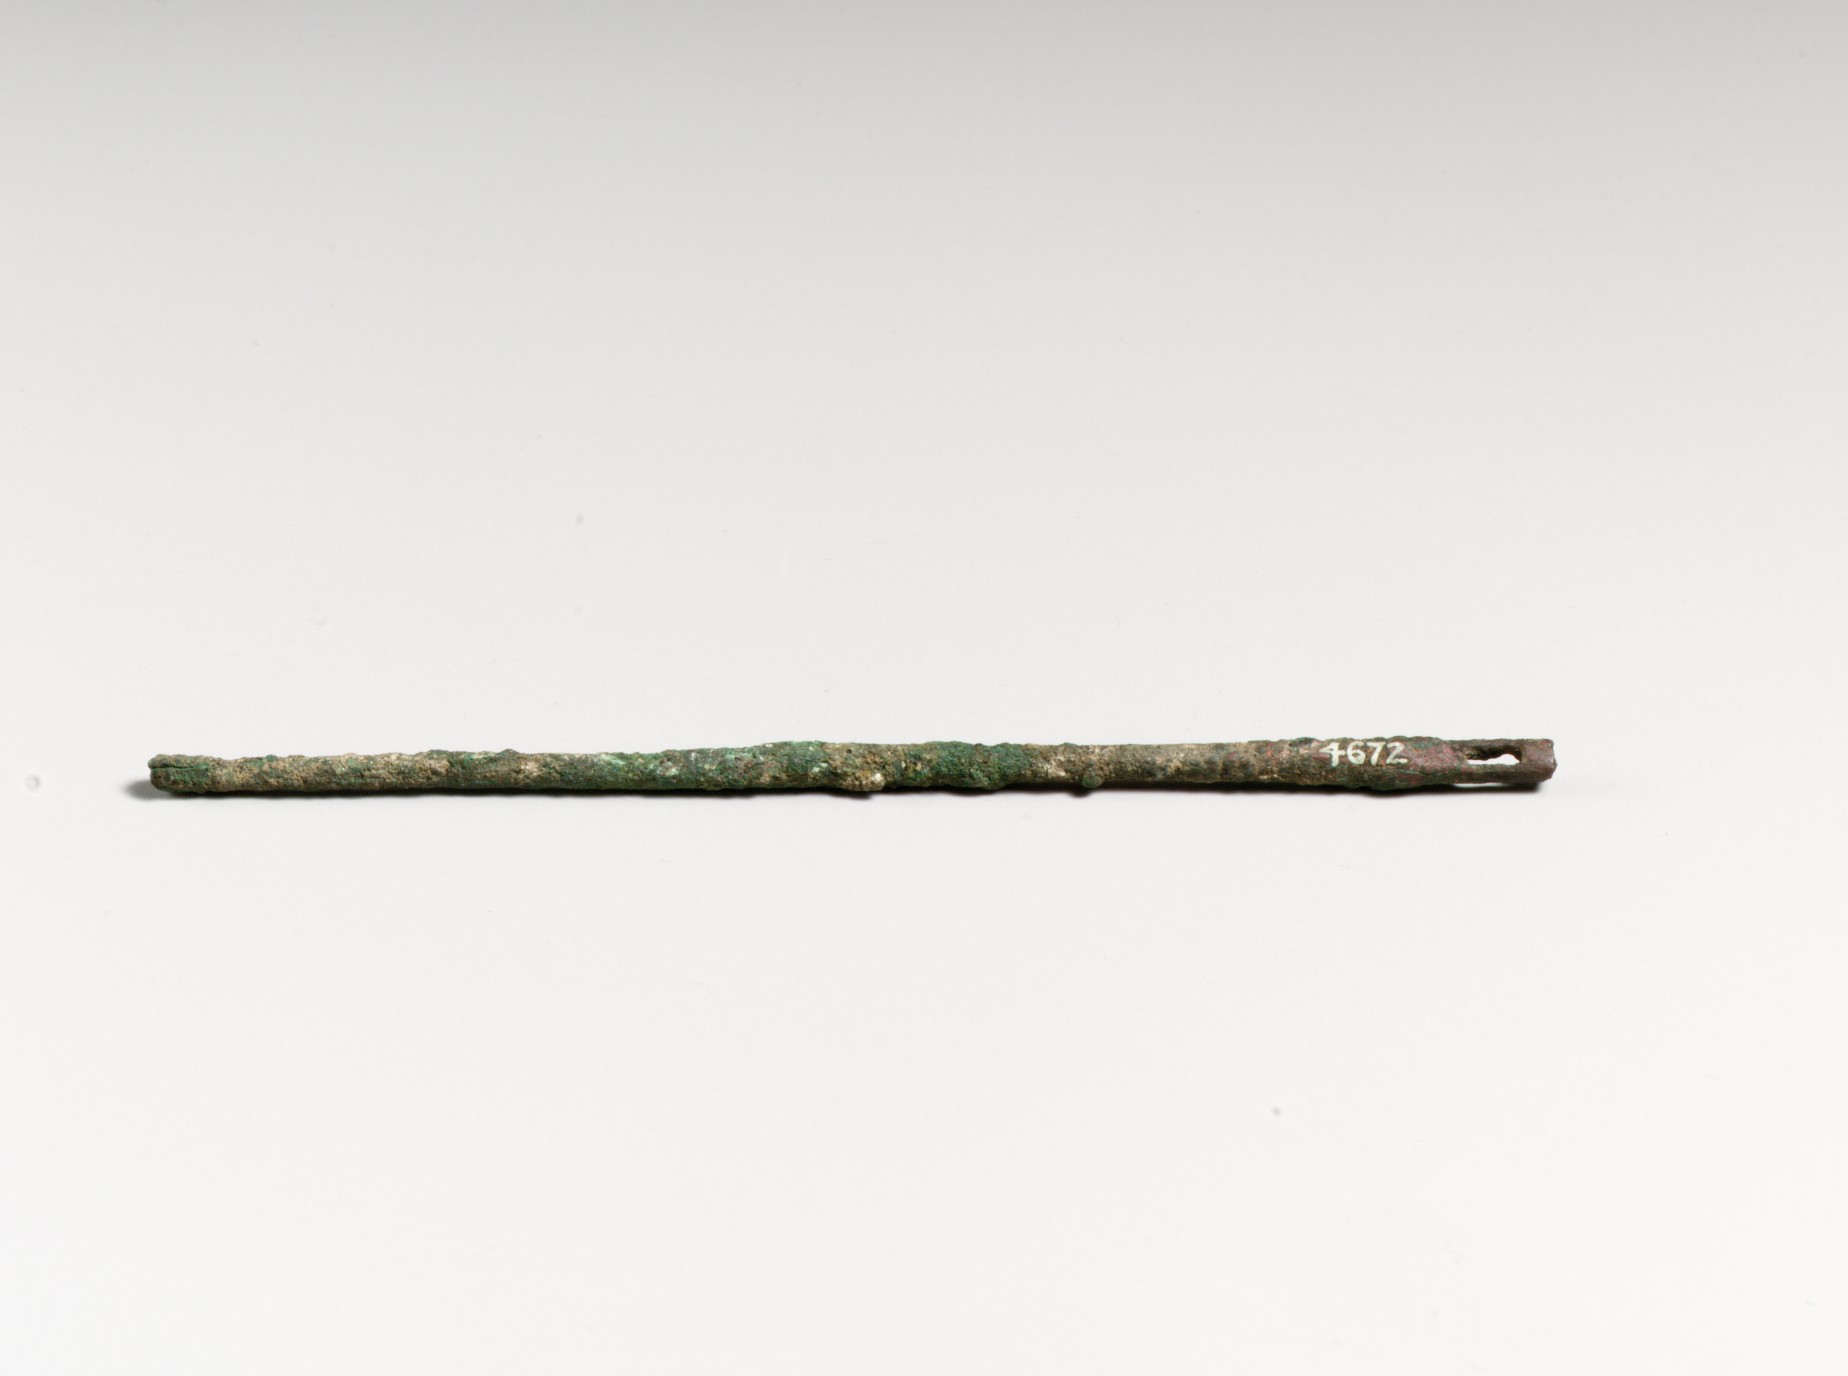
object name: needle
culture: cypriot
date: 3900 BCE-100 CE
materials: bronze